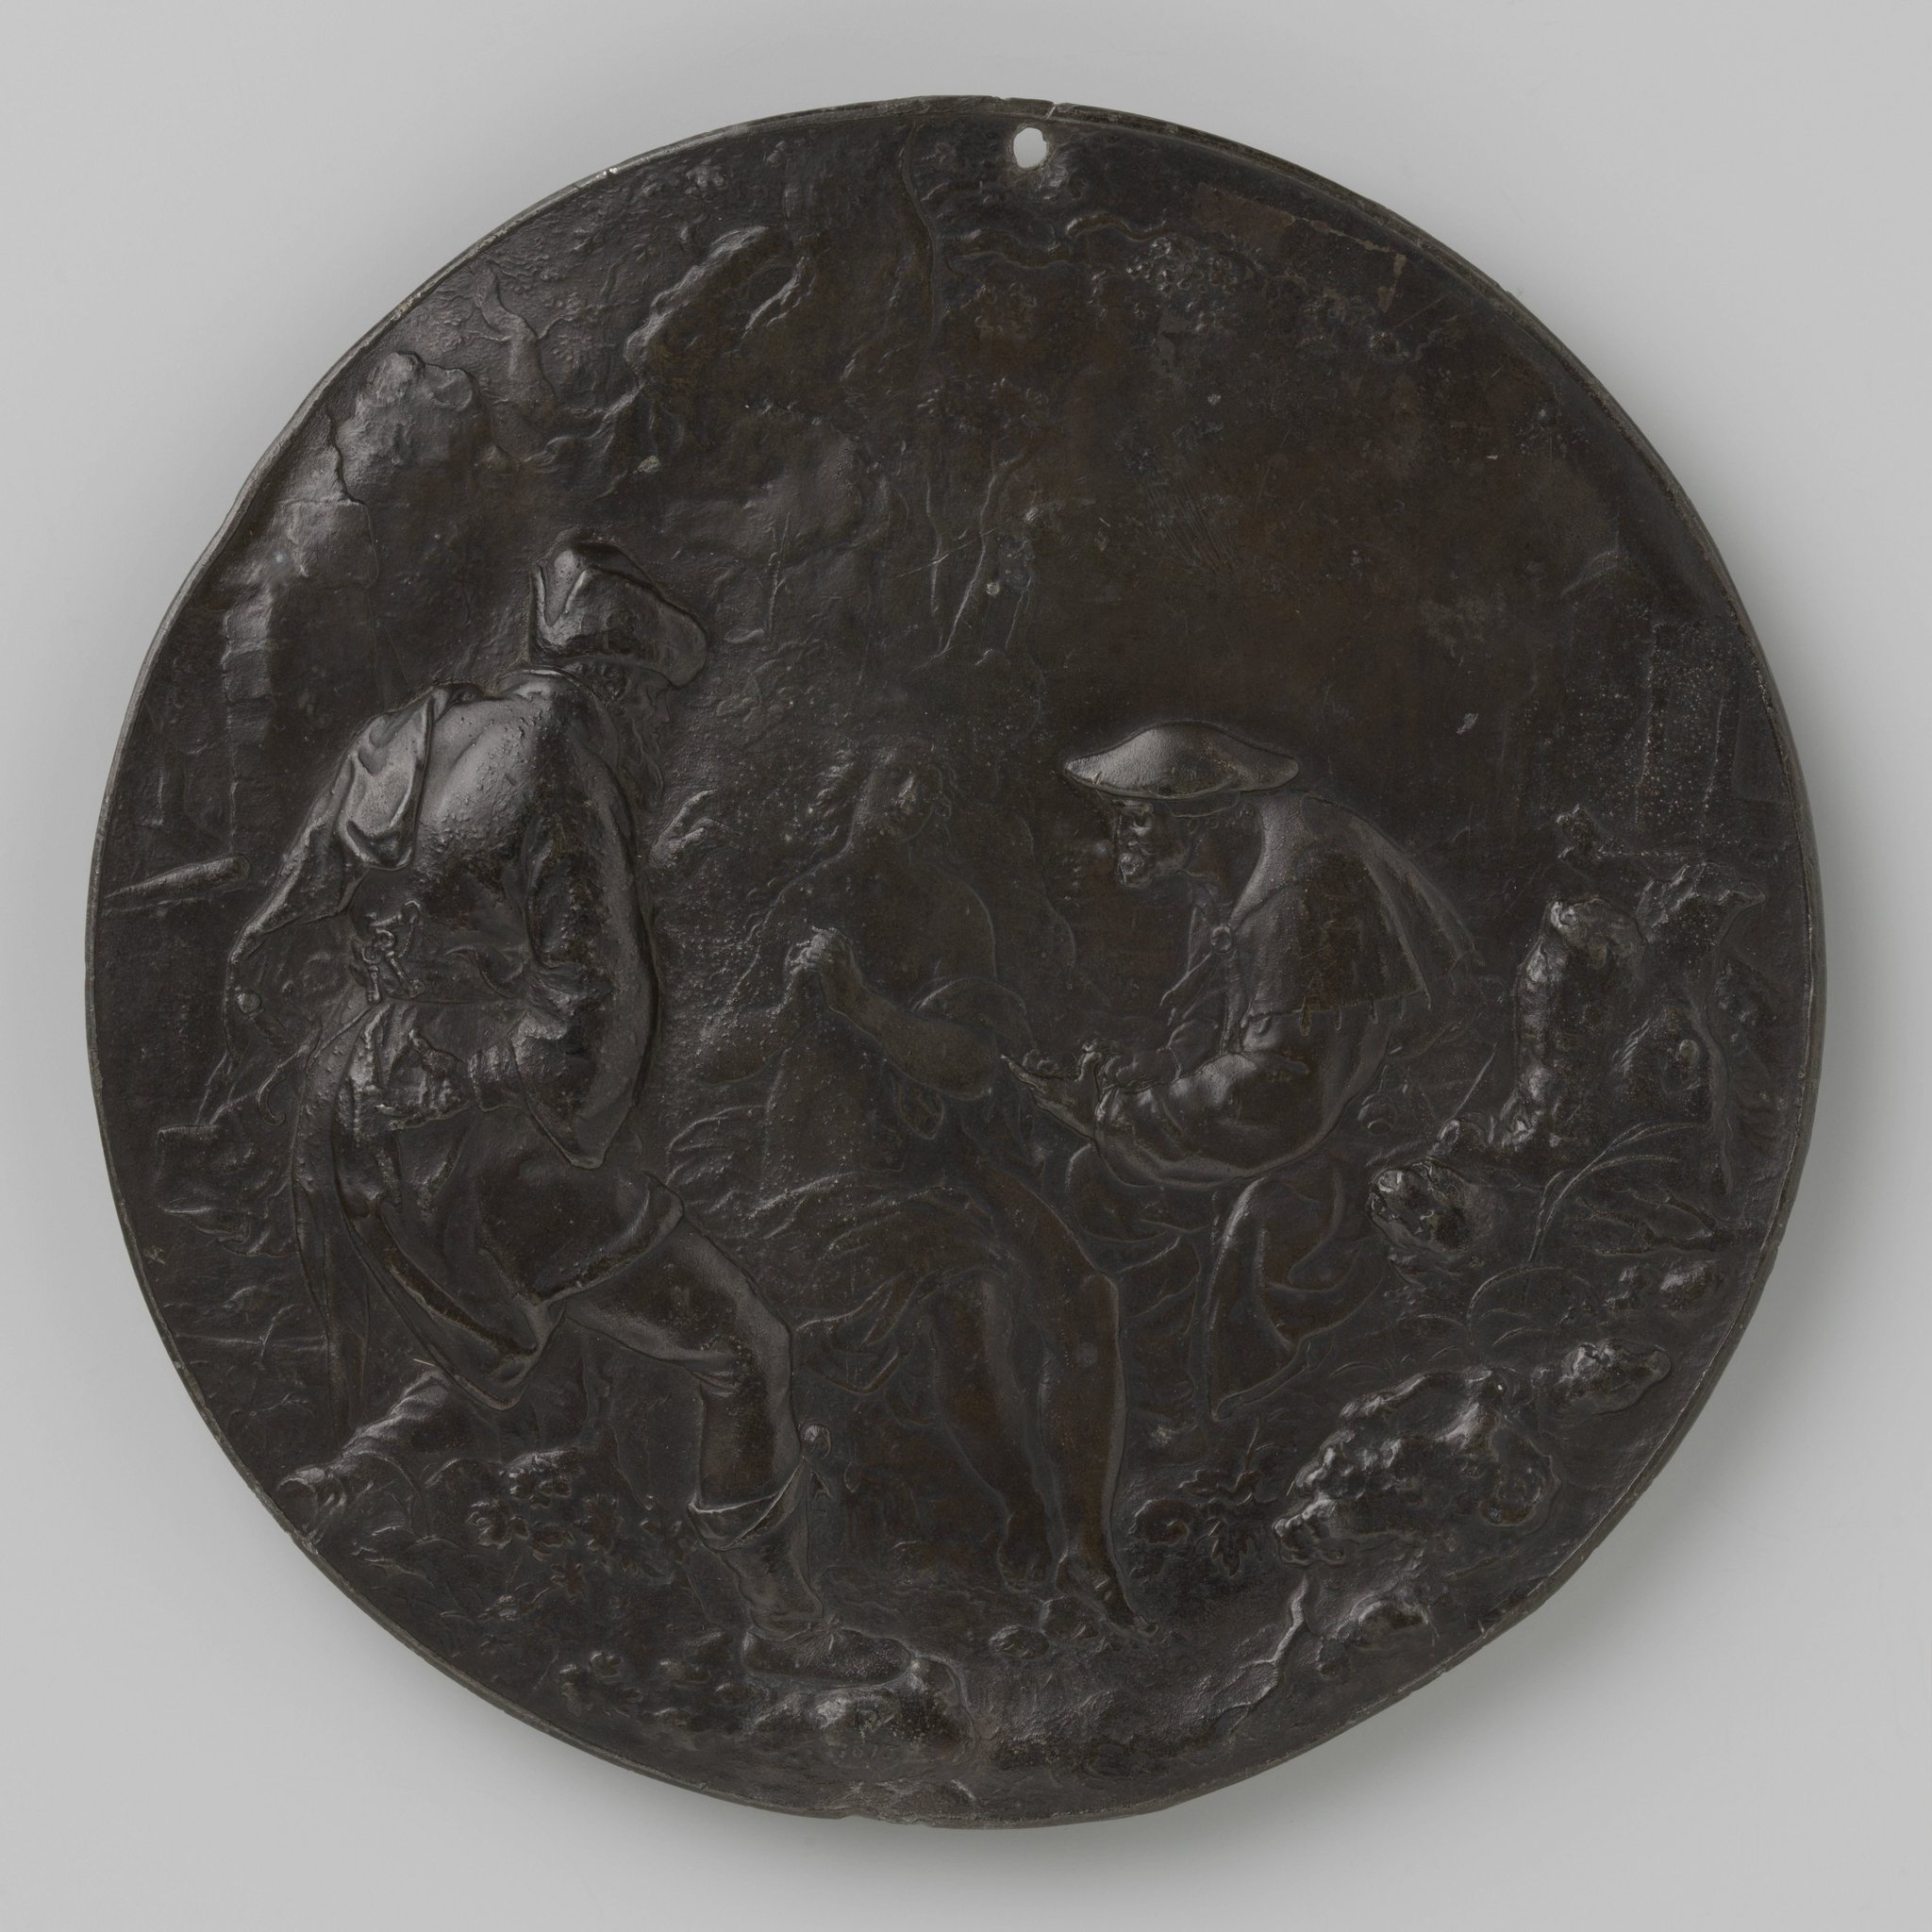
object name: plaque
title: Suzanna met de ouden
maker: paulus willemsz. van vianen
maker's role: draughtsman, jeweler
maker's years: 1570-1614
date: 1612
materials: lead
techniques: casting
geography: prague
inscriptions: monogram: ‘PV’, date: ‘1612’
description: Ronde, loden plaquette. Links op de voorgrond een der ouden, driekwart van achteren gezien; rechts achter een boomstronk de tweede in profiel, zich vooroverbuigende naar Suzanna, die op het middenplan, in smekende houding, met een kleine draperie over de linkerdij, naar achteren leunt. Rotsen en bomen op de achtergrond.